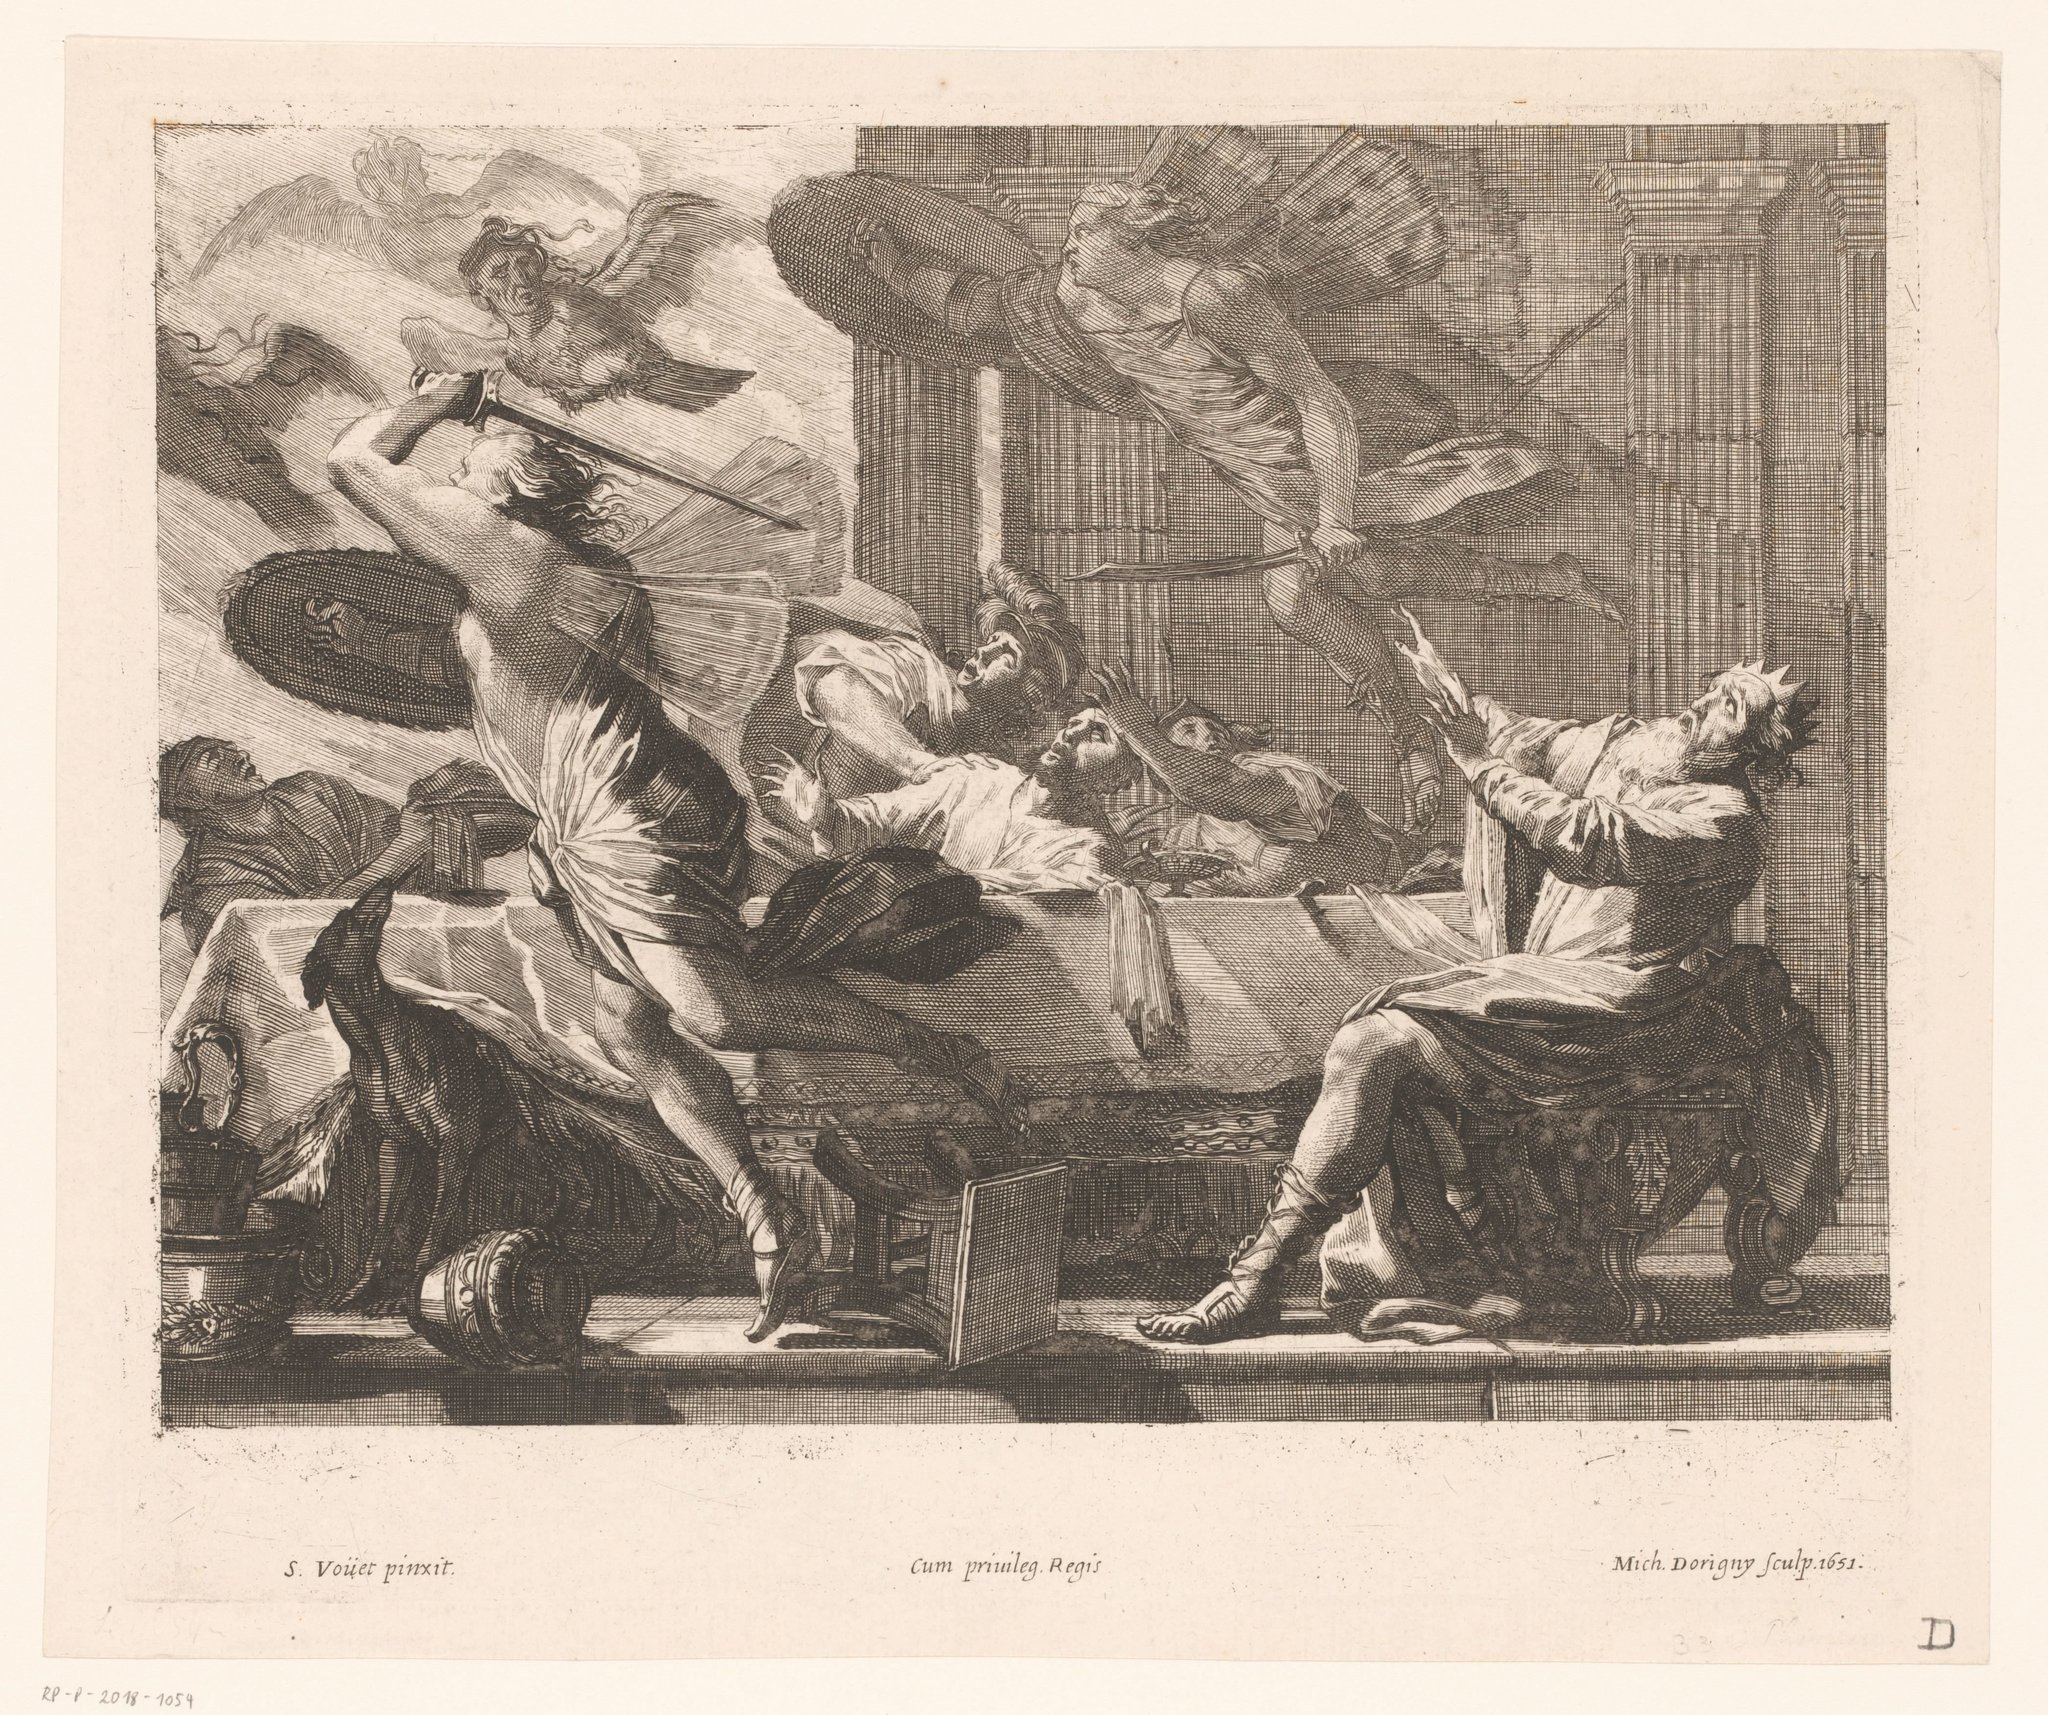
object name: print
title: Phineus en zijn volgelingen in steen veranderd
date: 1651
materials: paper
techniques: engraving, etching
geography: france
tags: phineus and his attendants are turned into stone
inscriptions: collector's mark: Lugt 2228